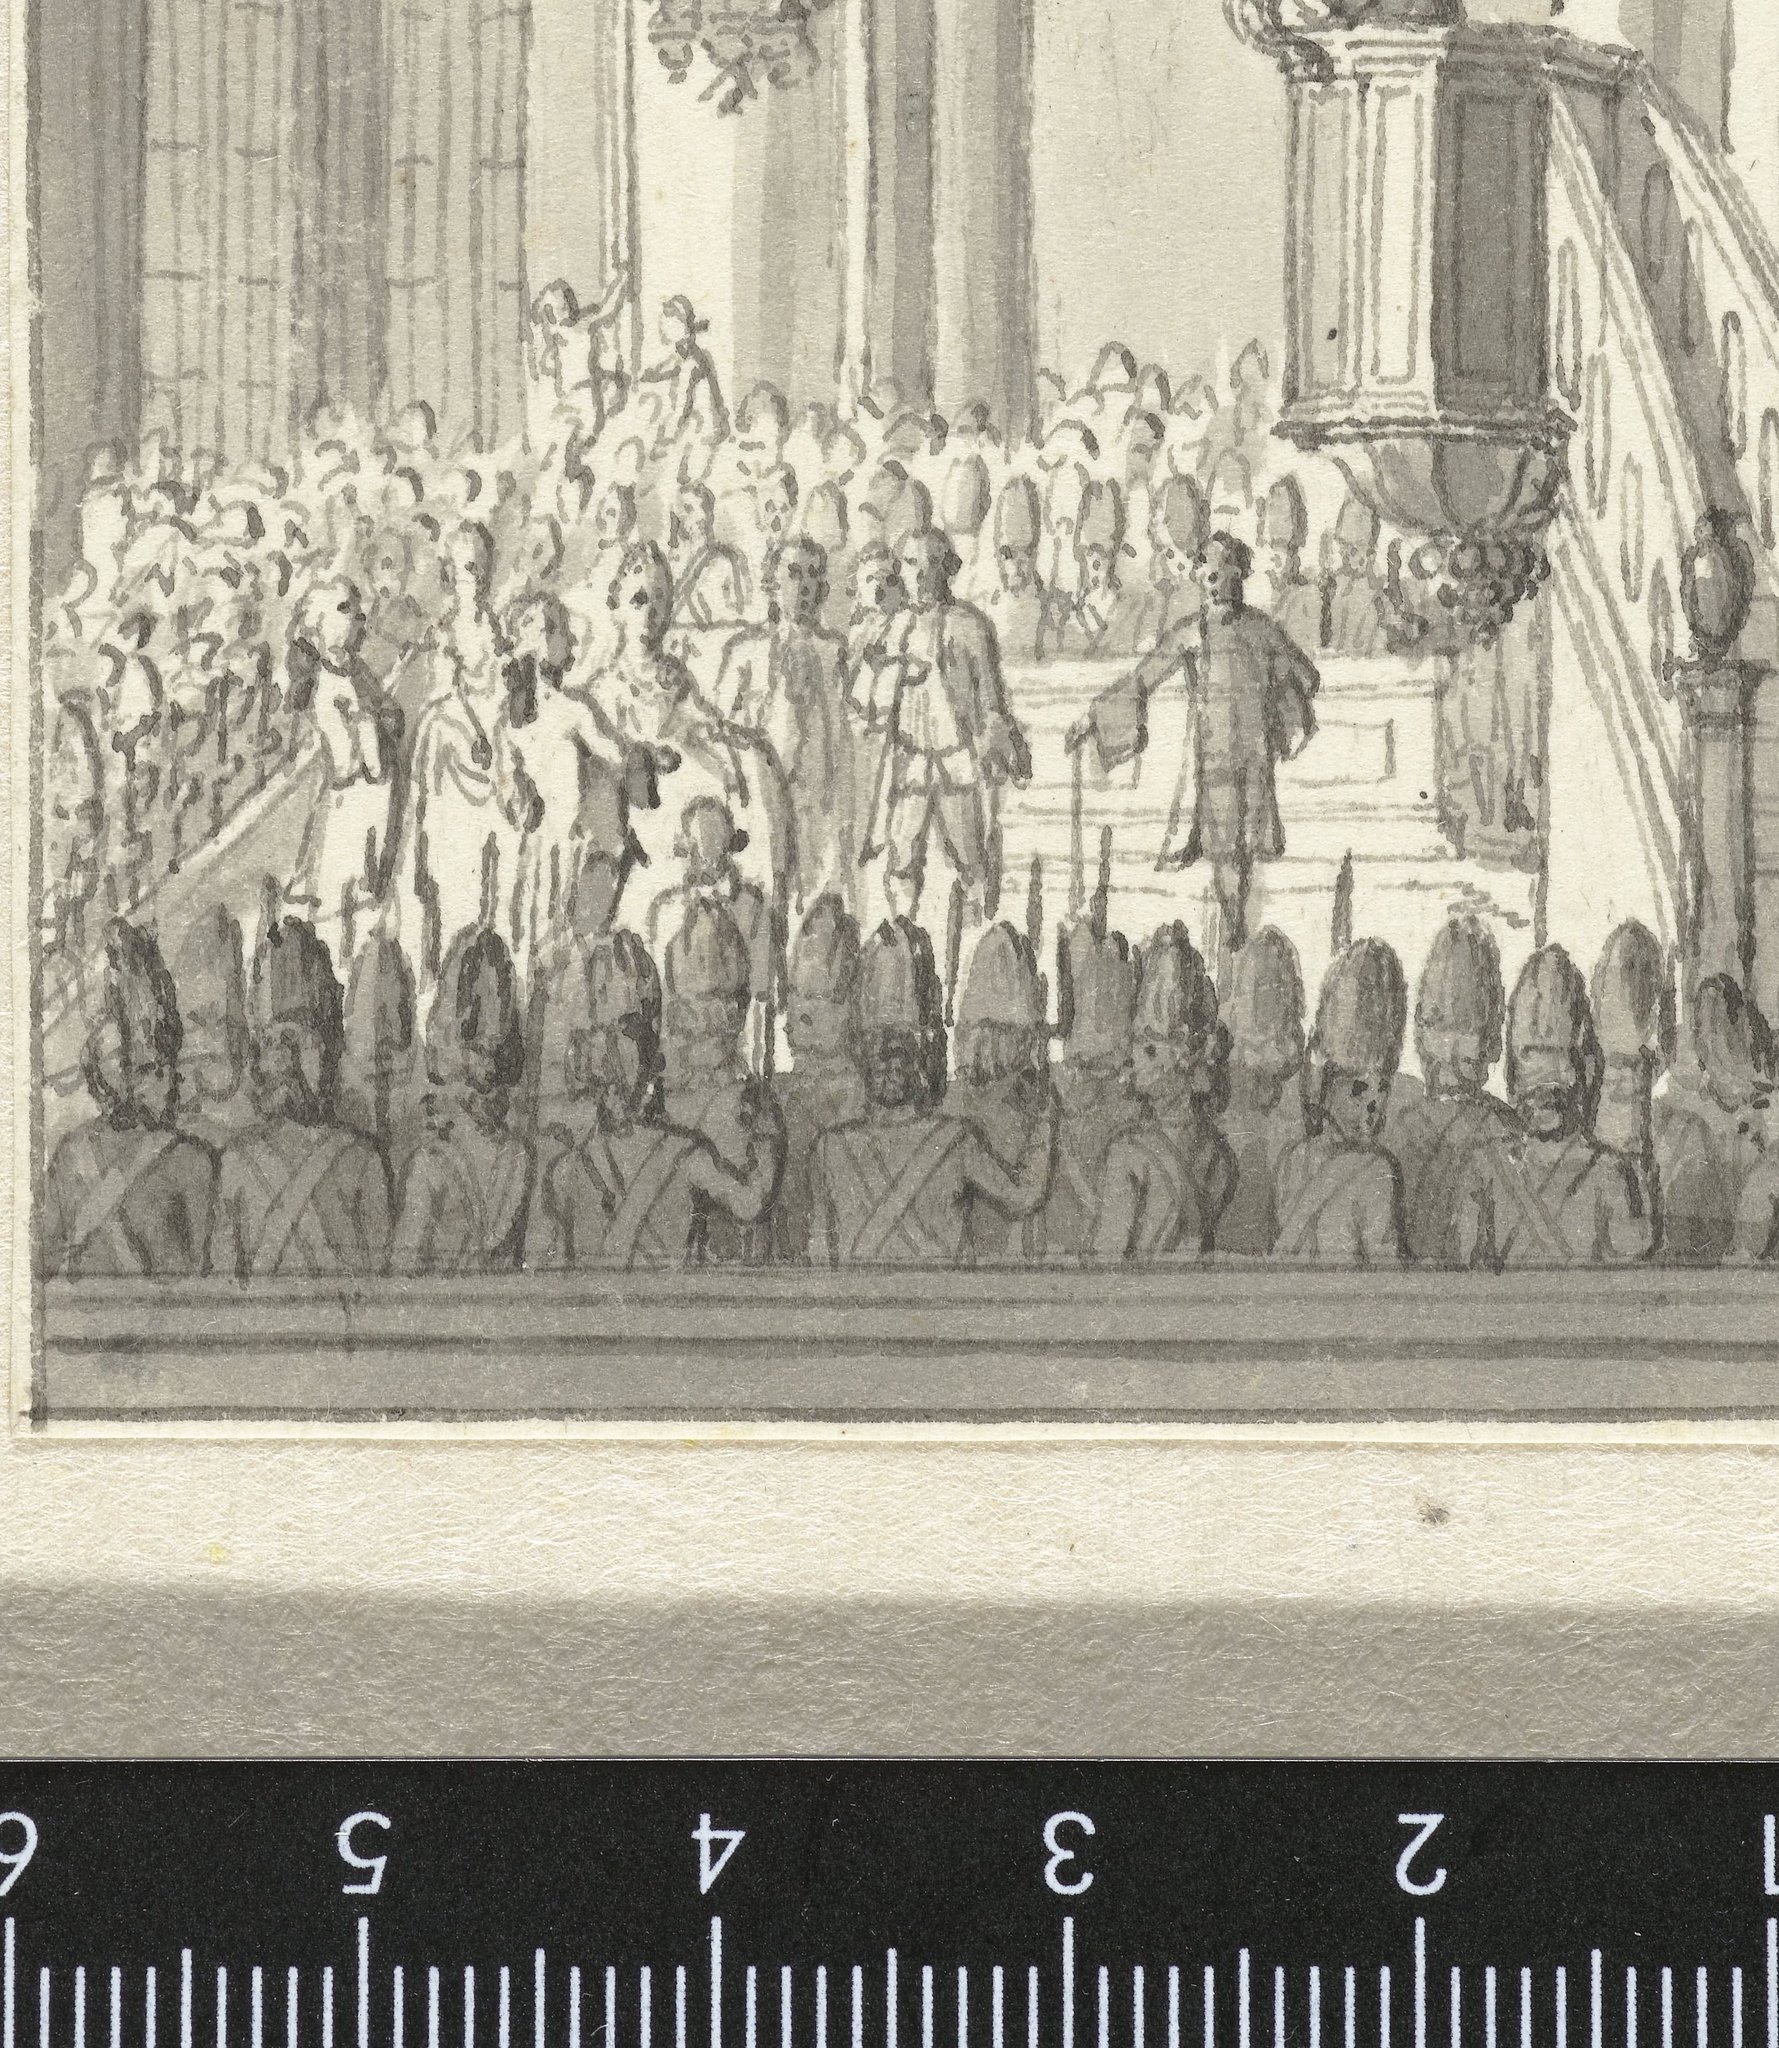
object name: design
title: In 't Jaar 1767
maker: Anonymous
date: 1789-1810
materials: ink, paper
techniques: brush, pen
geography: netherlands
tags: the hague, william v (prince of orange), berlin, painter, wilhelmina of prussia (princess of orange), (civil) marriage ceremonies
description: Huwelijk van stadhouder Willem V en prinses Wilhelmina van Pruisen te Berlijn op 4 oktober 1767.